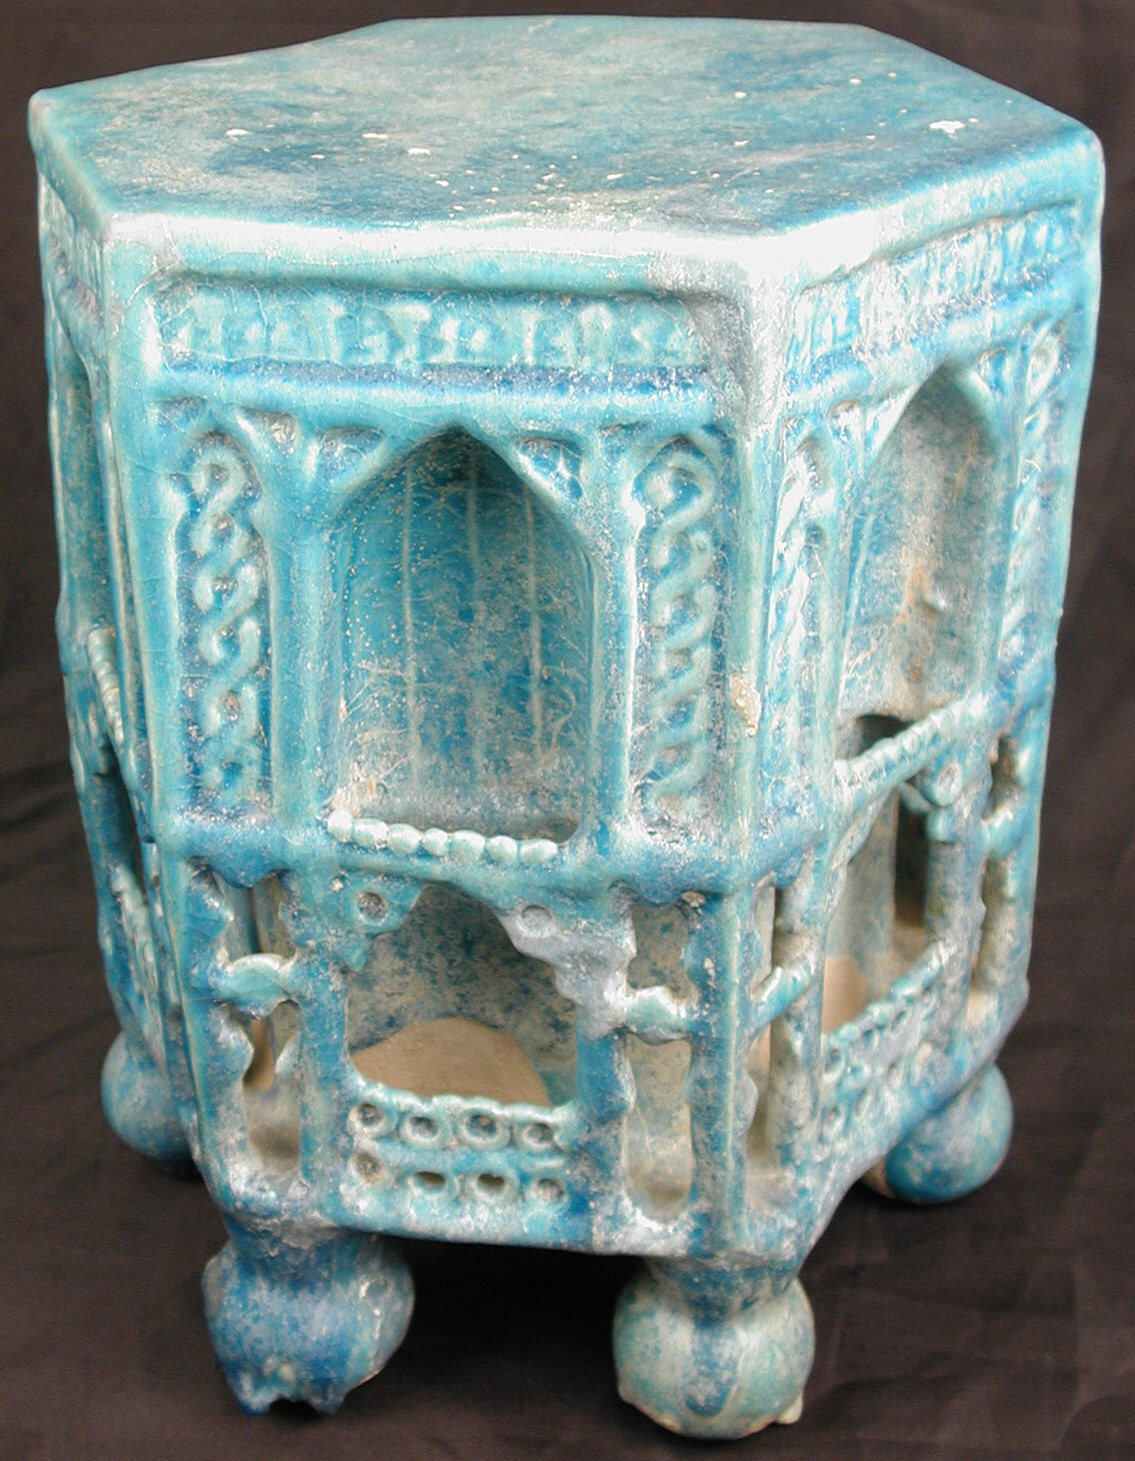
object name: table or stand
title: Low Table or Stand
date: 1101-1300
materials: stonepaste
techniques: glazing, molding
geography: iran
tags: tables